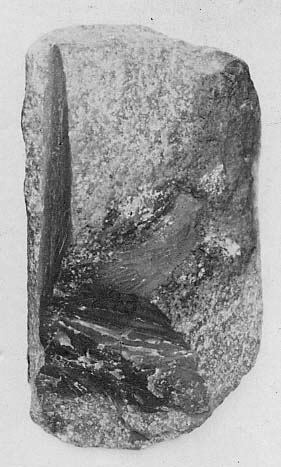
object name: axe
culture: north american, alaskan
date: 1902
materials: jade